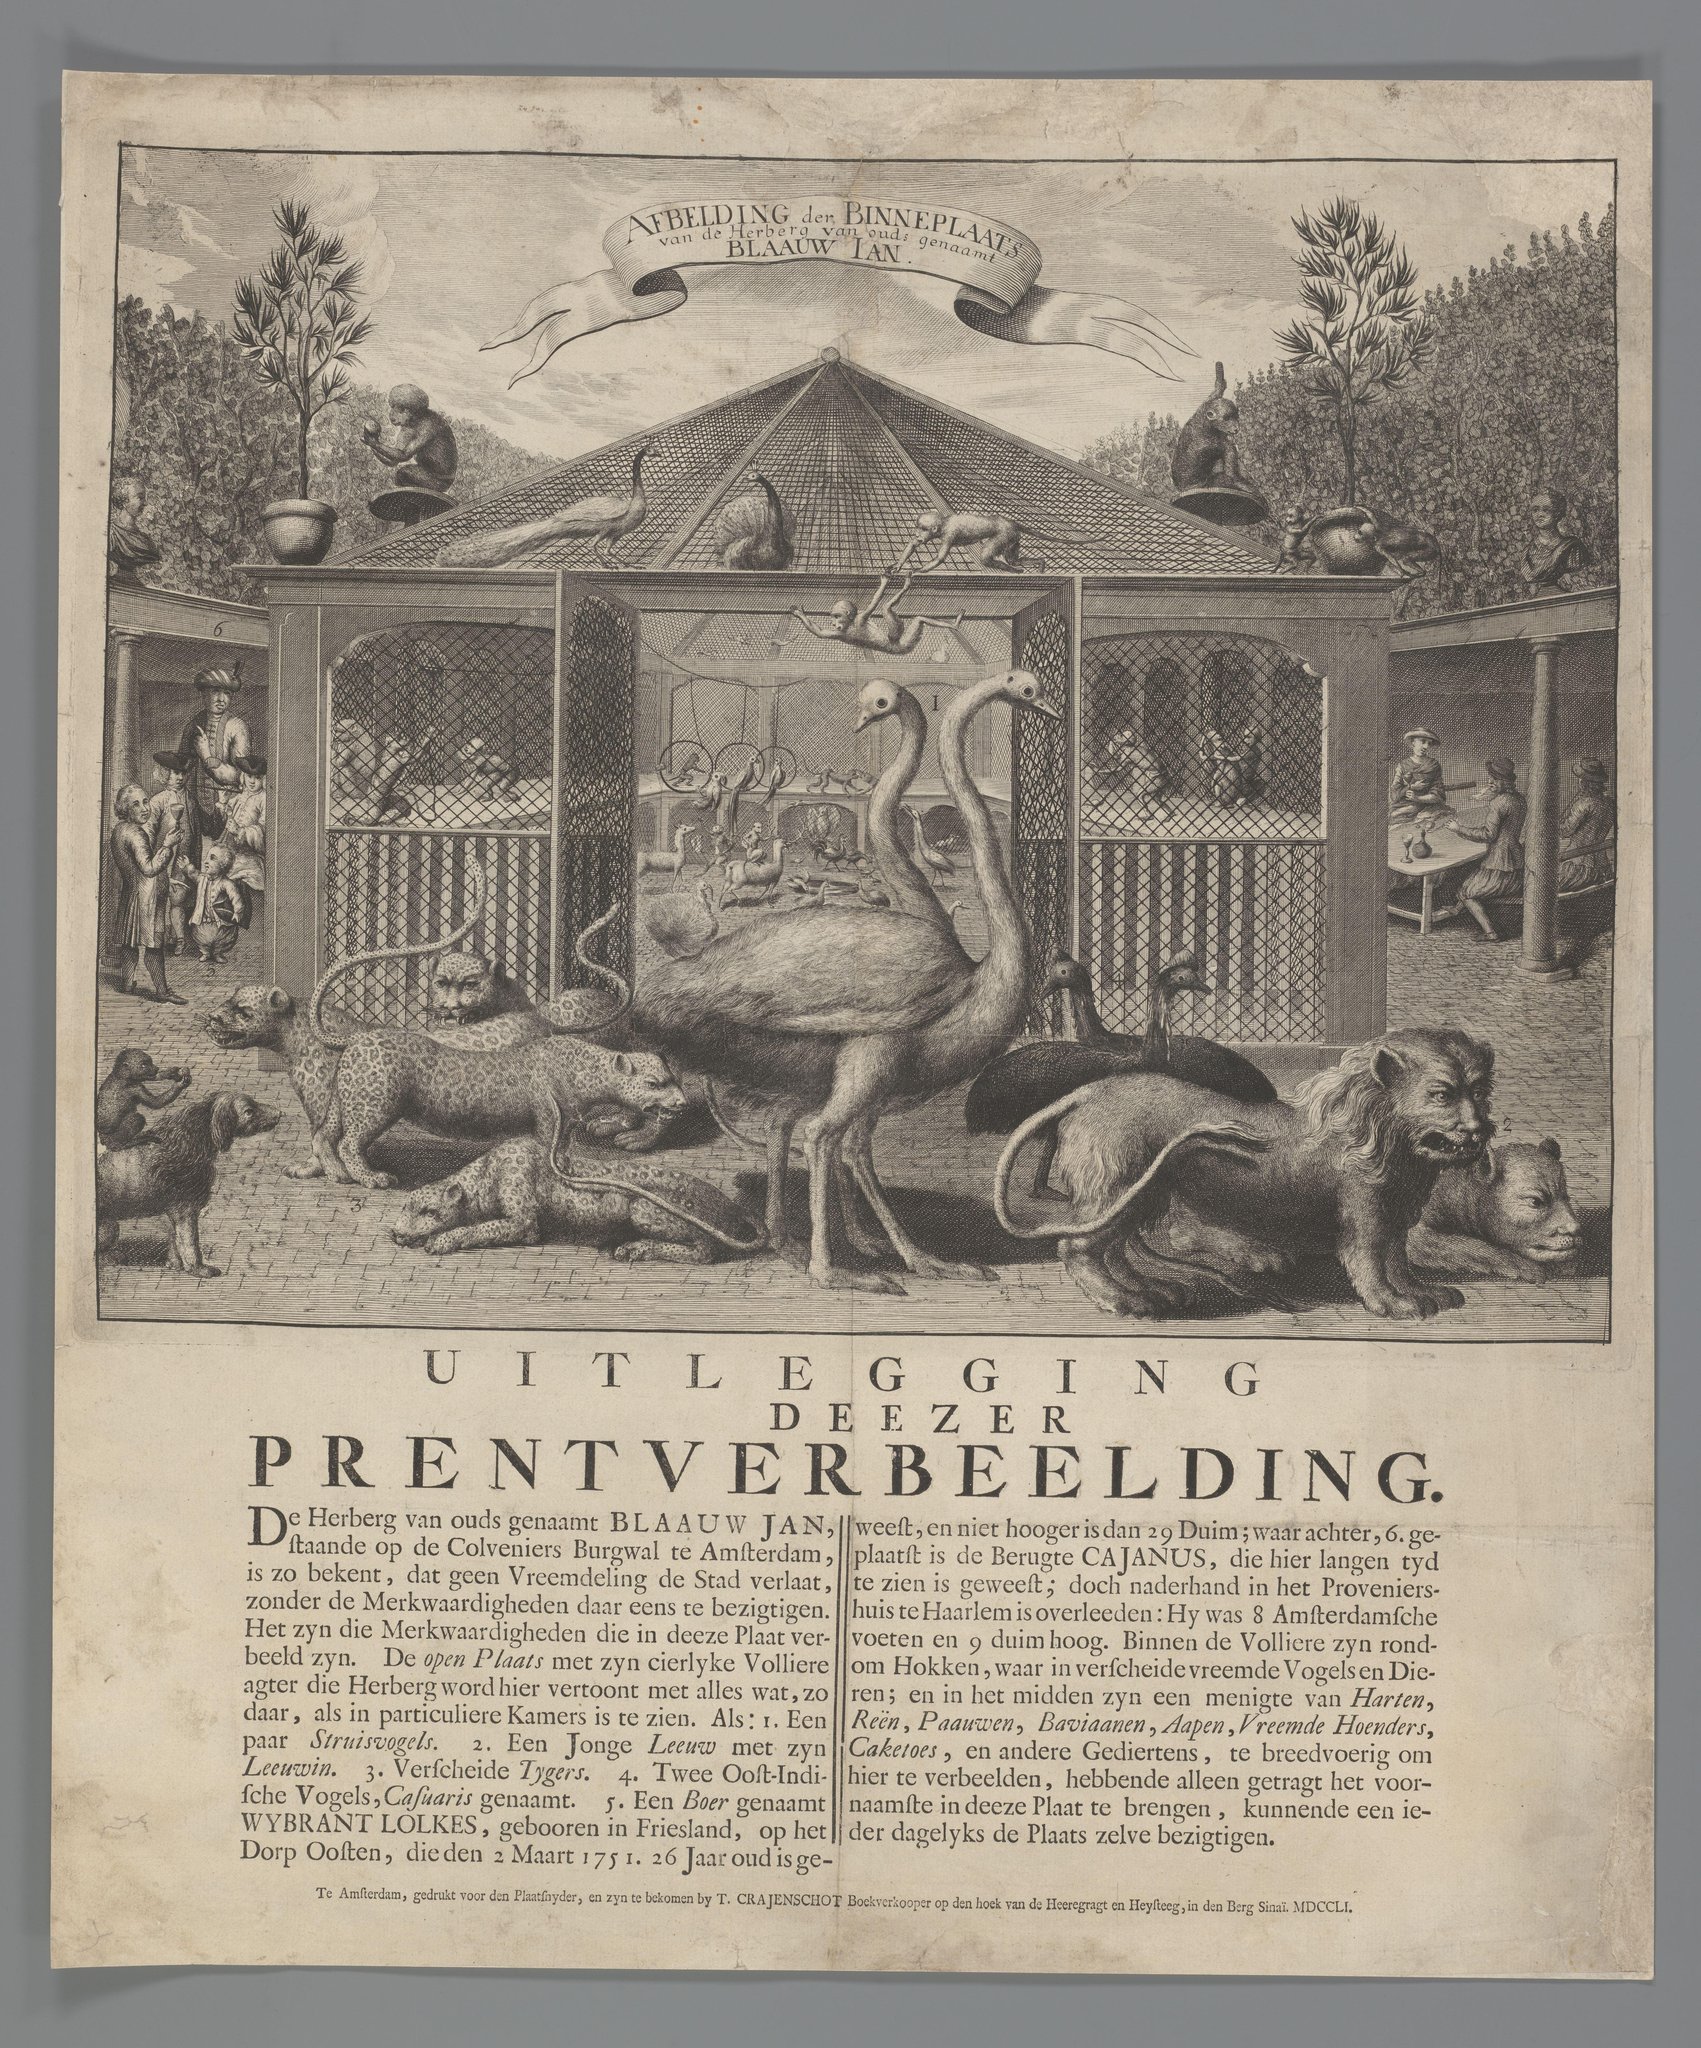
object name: print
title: Menagerie van Blaauw Jan, 1751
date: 1751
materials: paper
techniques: engraving, etching, letterpress printing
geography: amsterdam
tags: birds in a large cage, aviary, little people, zoological garden, zoo, seen as place where non-domestic animals are kept, (human) skeleton - aa - female human figure, zoo (as place of recreation)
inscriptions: date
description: Menagerie op de binnenplaats van de herberg van Jan Berentsz Westerhof of Blaauw Jan op de Kloveniersburgwal te Amsterdam in 1751: een hof met in het midden een volière met struisvogels, pauwen, kasuarissen, papegaaien en een raaf. Op de voorgrond een leeuw, panters, apen en een jonge walrus. Volgens de uitleg bij de prent waren deze dieren, evenals de Friese kleine mens Wybren Lolkes en de Finse reus Daniel Cajanus, hier ook te bewonderen.